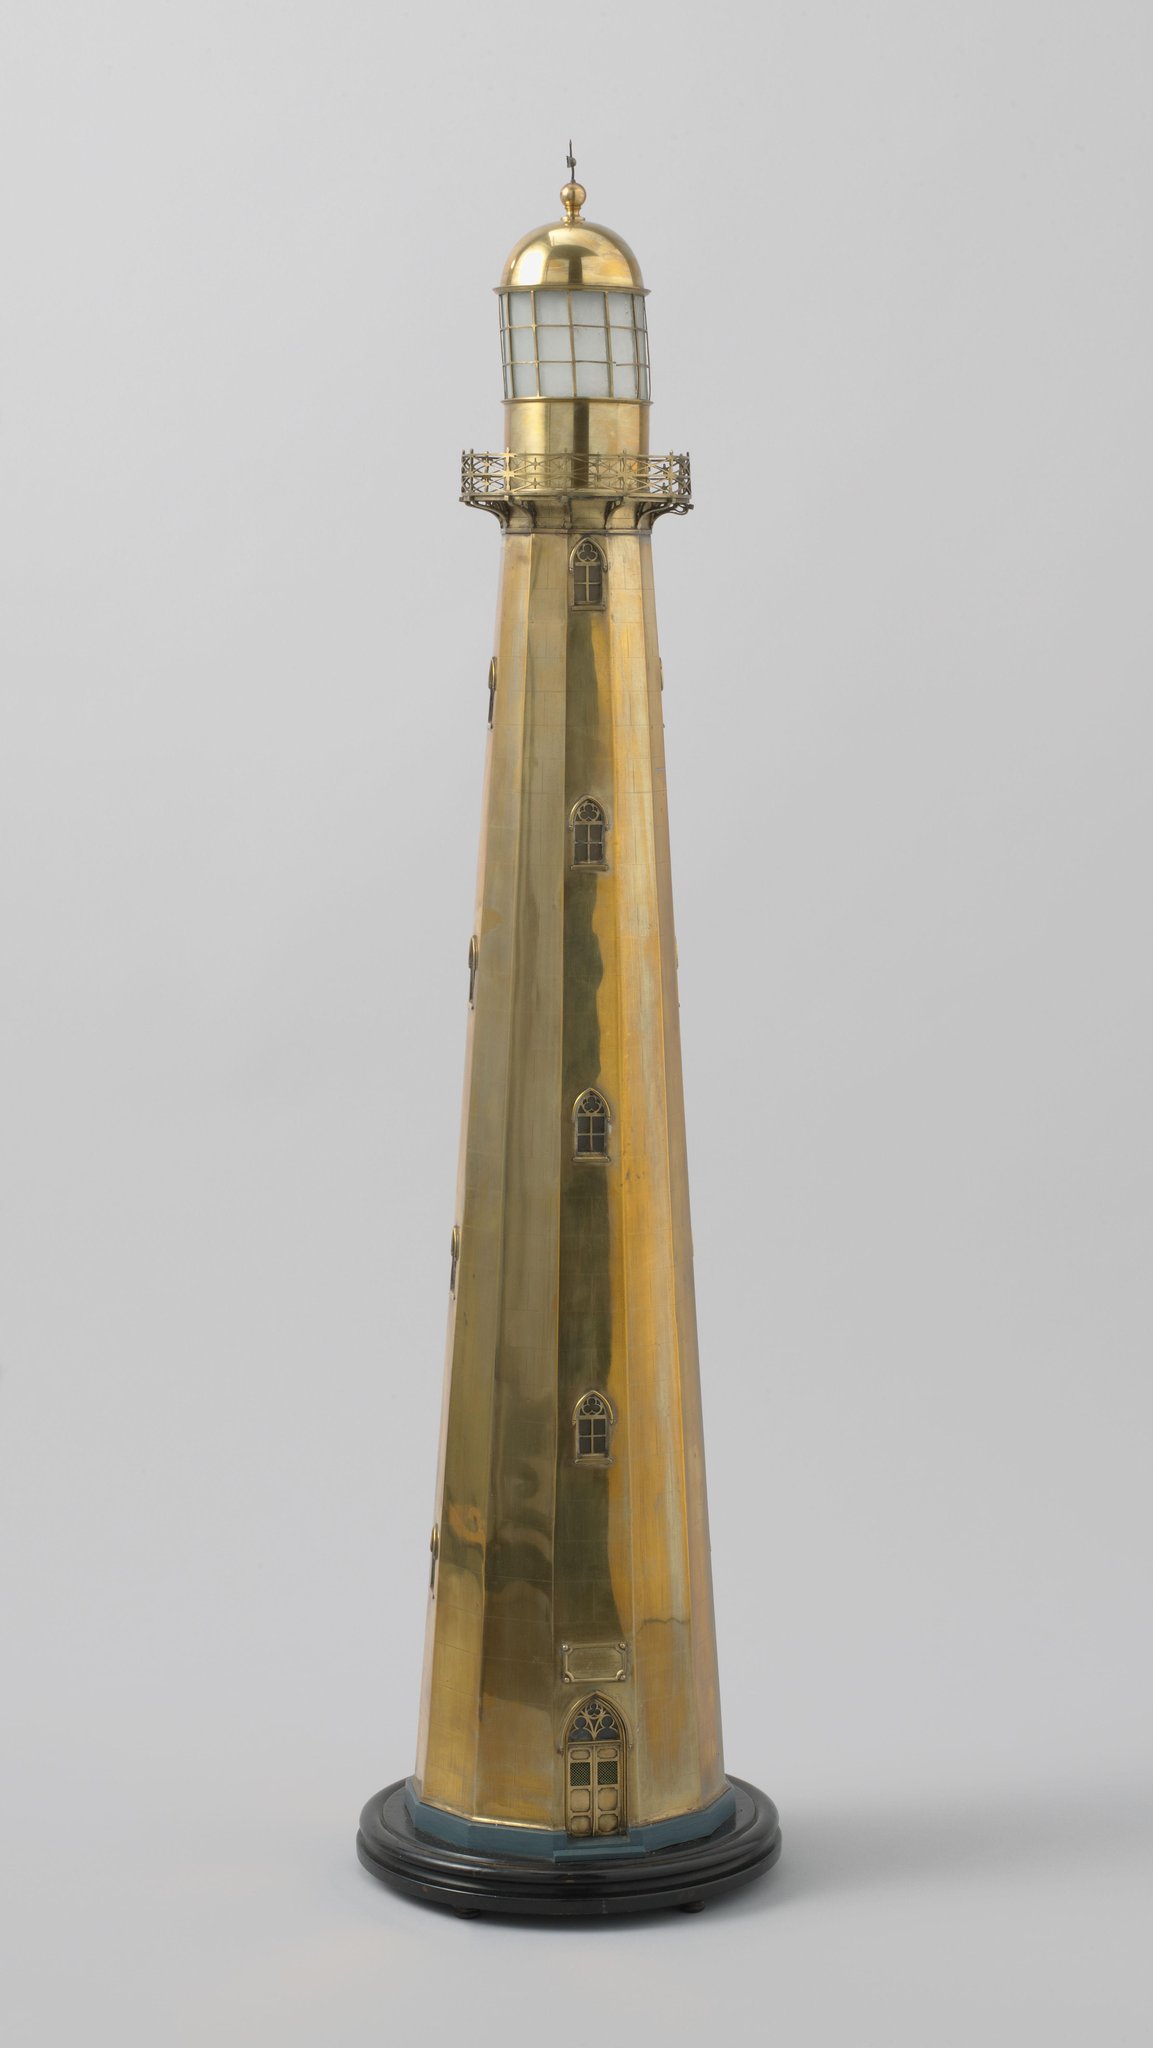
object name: scale model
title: Model of a Lighthouse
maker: quirinus harder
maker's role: designer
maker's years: 1801-1880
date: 1875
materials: brass, glass, wood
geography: deventer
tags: lighthouse, lightship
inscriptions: inscription, above the door: ‘ONTWORPEN DOOR / Q. HARDER / BOUWKUNDIGE BY DE DIENST / DRE VERLICHTING ENZ / VERVAARDIGT DOOR / J.L. NERING BÖGEL & Co / FABRIKANTEN TE DEVENTER: / 1875 ONDER REGERING VAN / WILLEM III/ KONING DER NEDERLANDEN / ENZ. ENZ. ENZ. / TYDENS HET BESTUUR VAN DEN / MINISTER VAN MARINE / W.F. VAN ERP TAALMAN KIP / VOOR DRAAILICHT 2E GROOTTE / 1875’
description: Messing model van de vuurtoren van Scheveningen, op houten sokkel. Twaalfkantige gesloten vuurtoren met twee deuren en zestien ramen; de deuren en ramen hebben spitsbogen met drievoudige lobben. Boven iedere deur is een opschrift aangebracht. De kuip heeft een koepelvormig dak met windvaan. Schaal 1:30 (afgeleid).